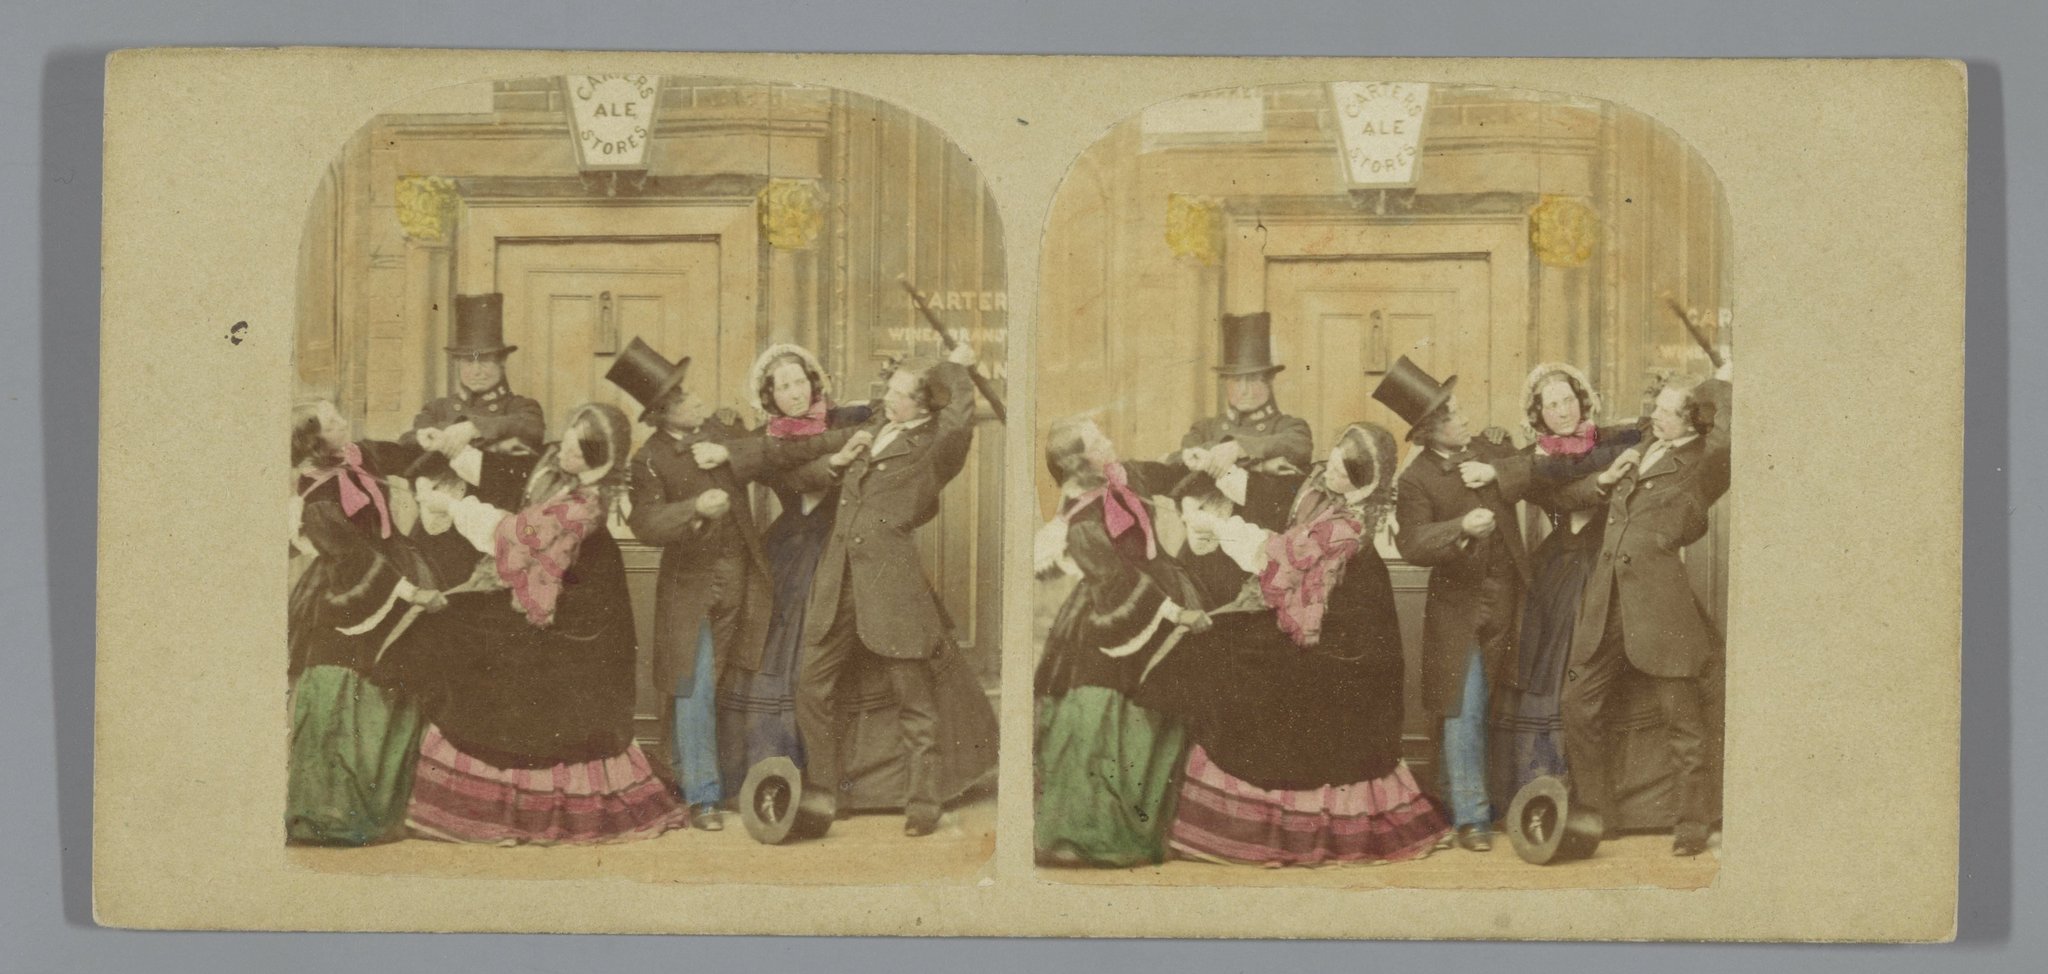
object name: stereograph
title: Vechtende mannen en vrouwen voor een kroeg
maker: Anonymous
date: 1852-1863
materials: cardboard, paper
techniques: albumen print, hand coloring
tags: inn, coffee-house, public house, etc., fighting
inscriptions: inscription: ‘J. C. MEERBURG,’, stamp: ‘S. A. MEERBURG/ LEIJDEN’